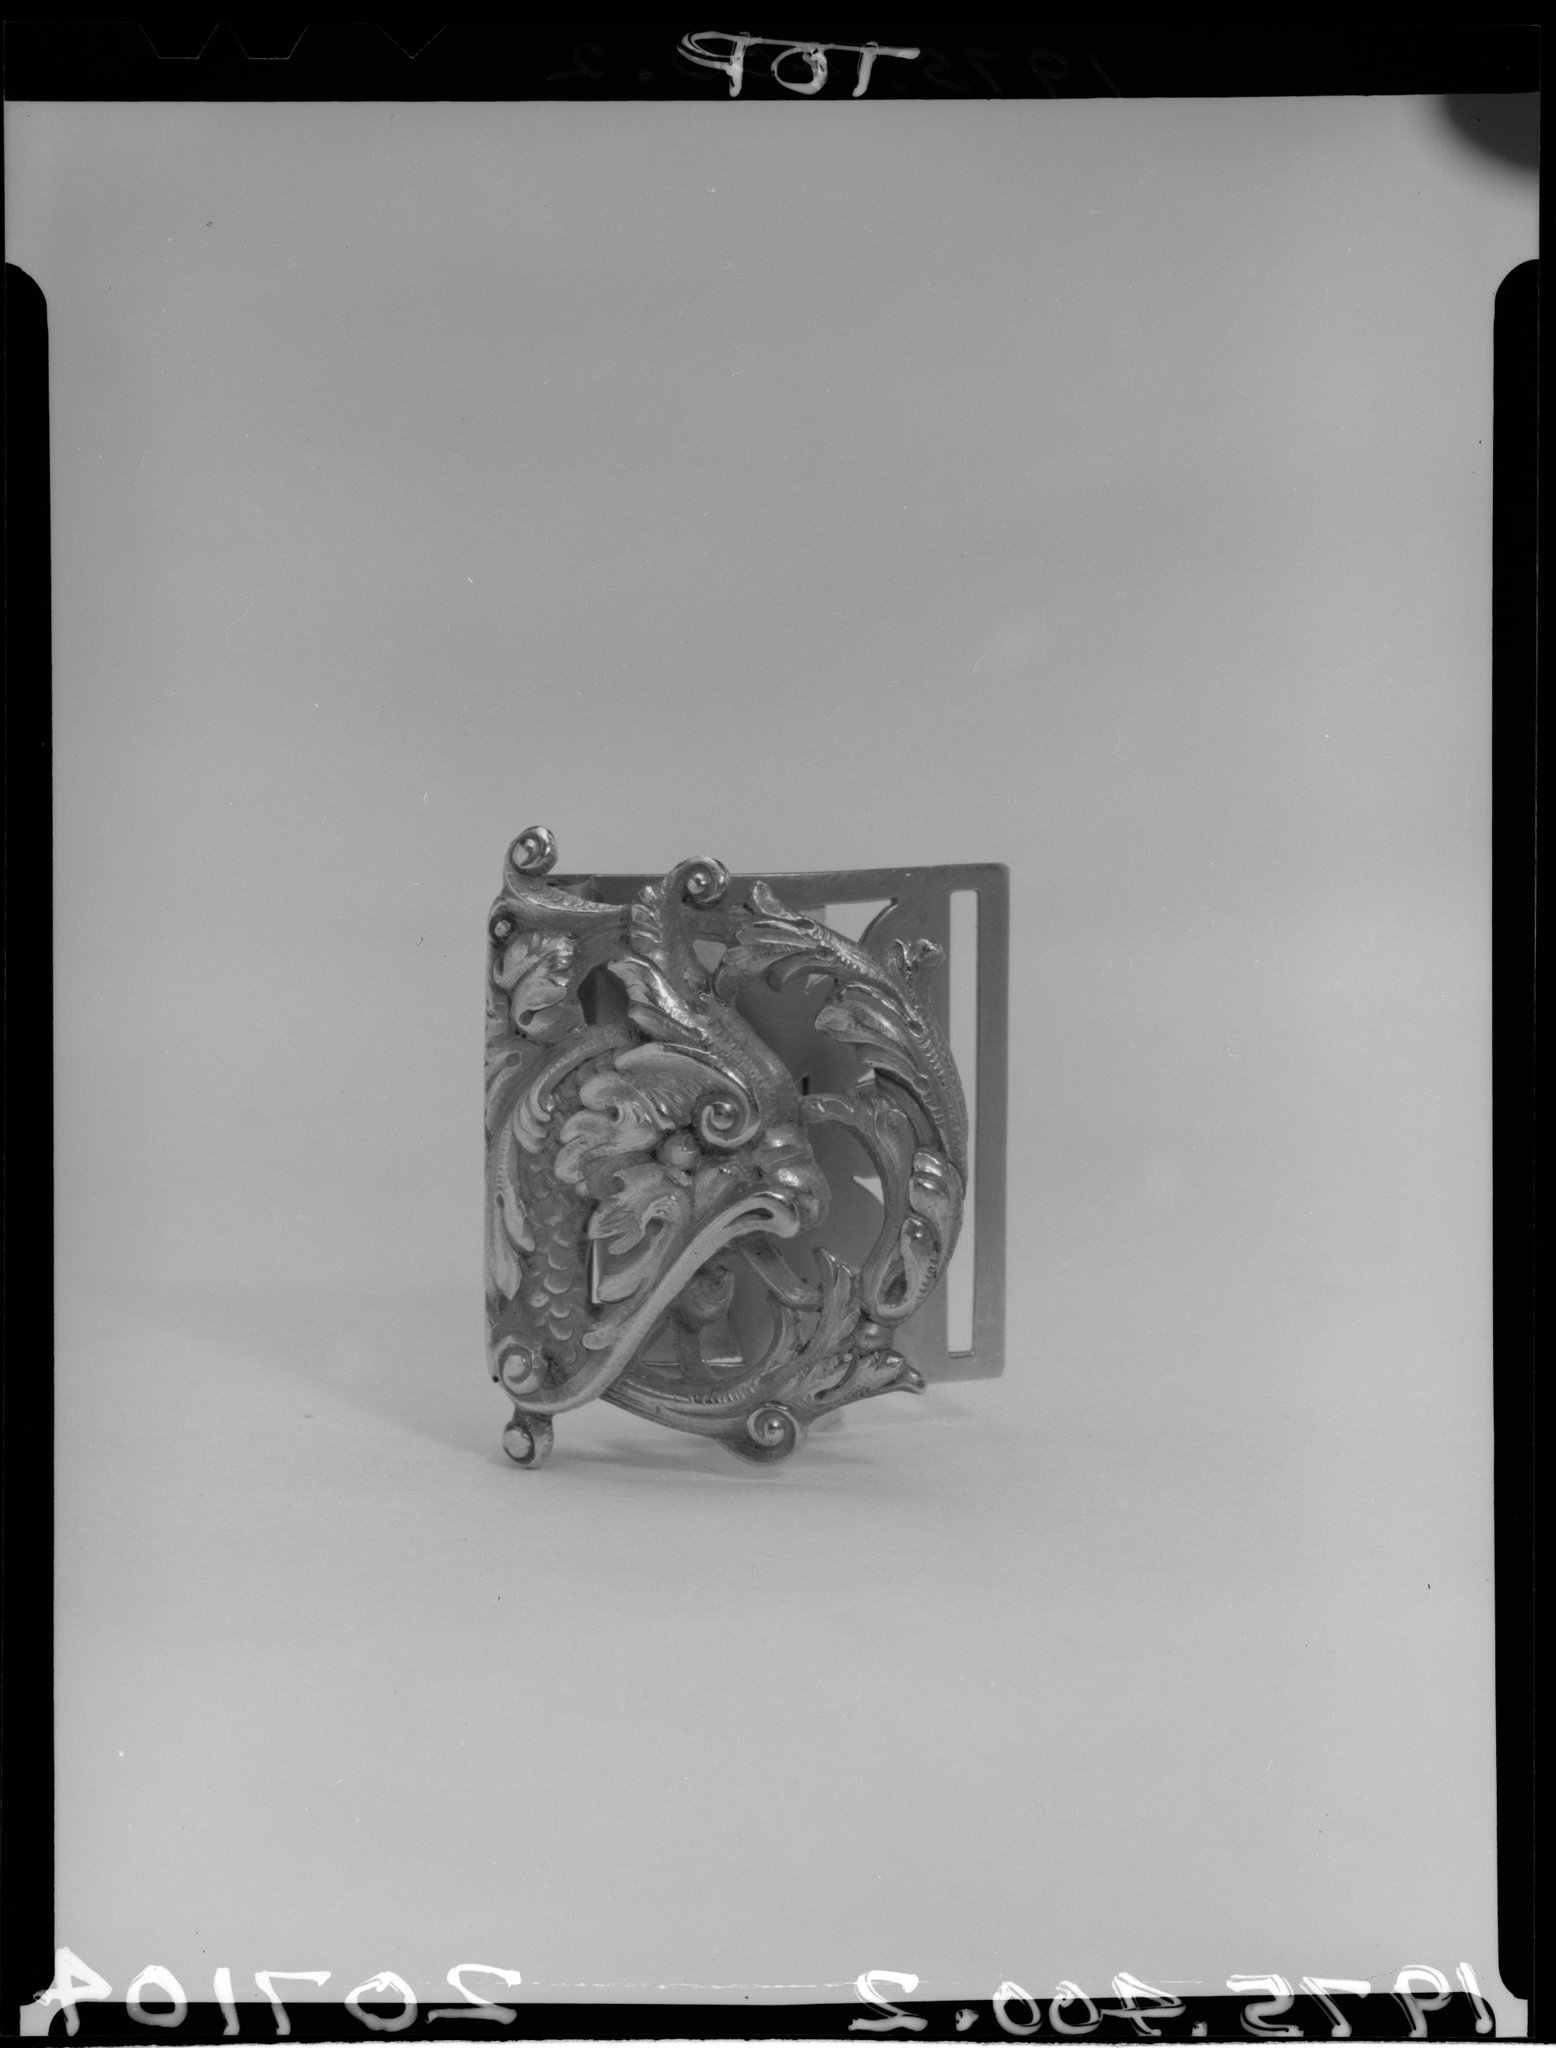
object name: buckle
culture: american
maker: theodore b. starr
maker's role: maker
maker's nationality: american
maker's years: 1837-1907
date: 1900-1924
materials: gold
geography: united states